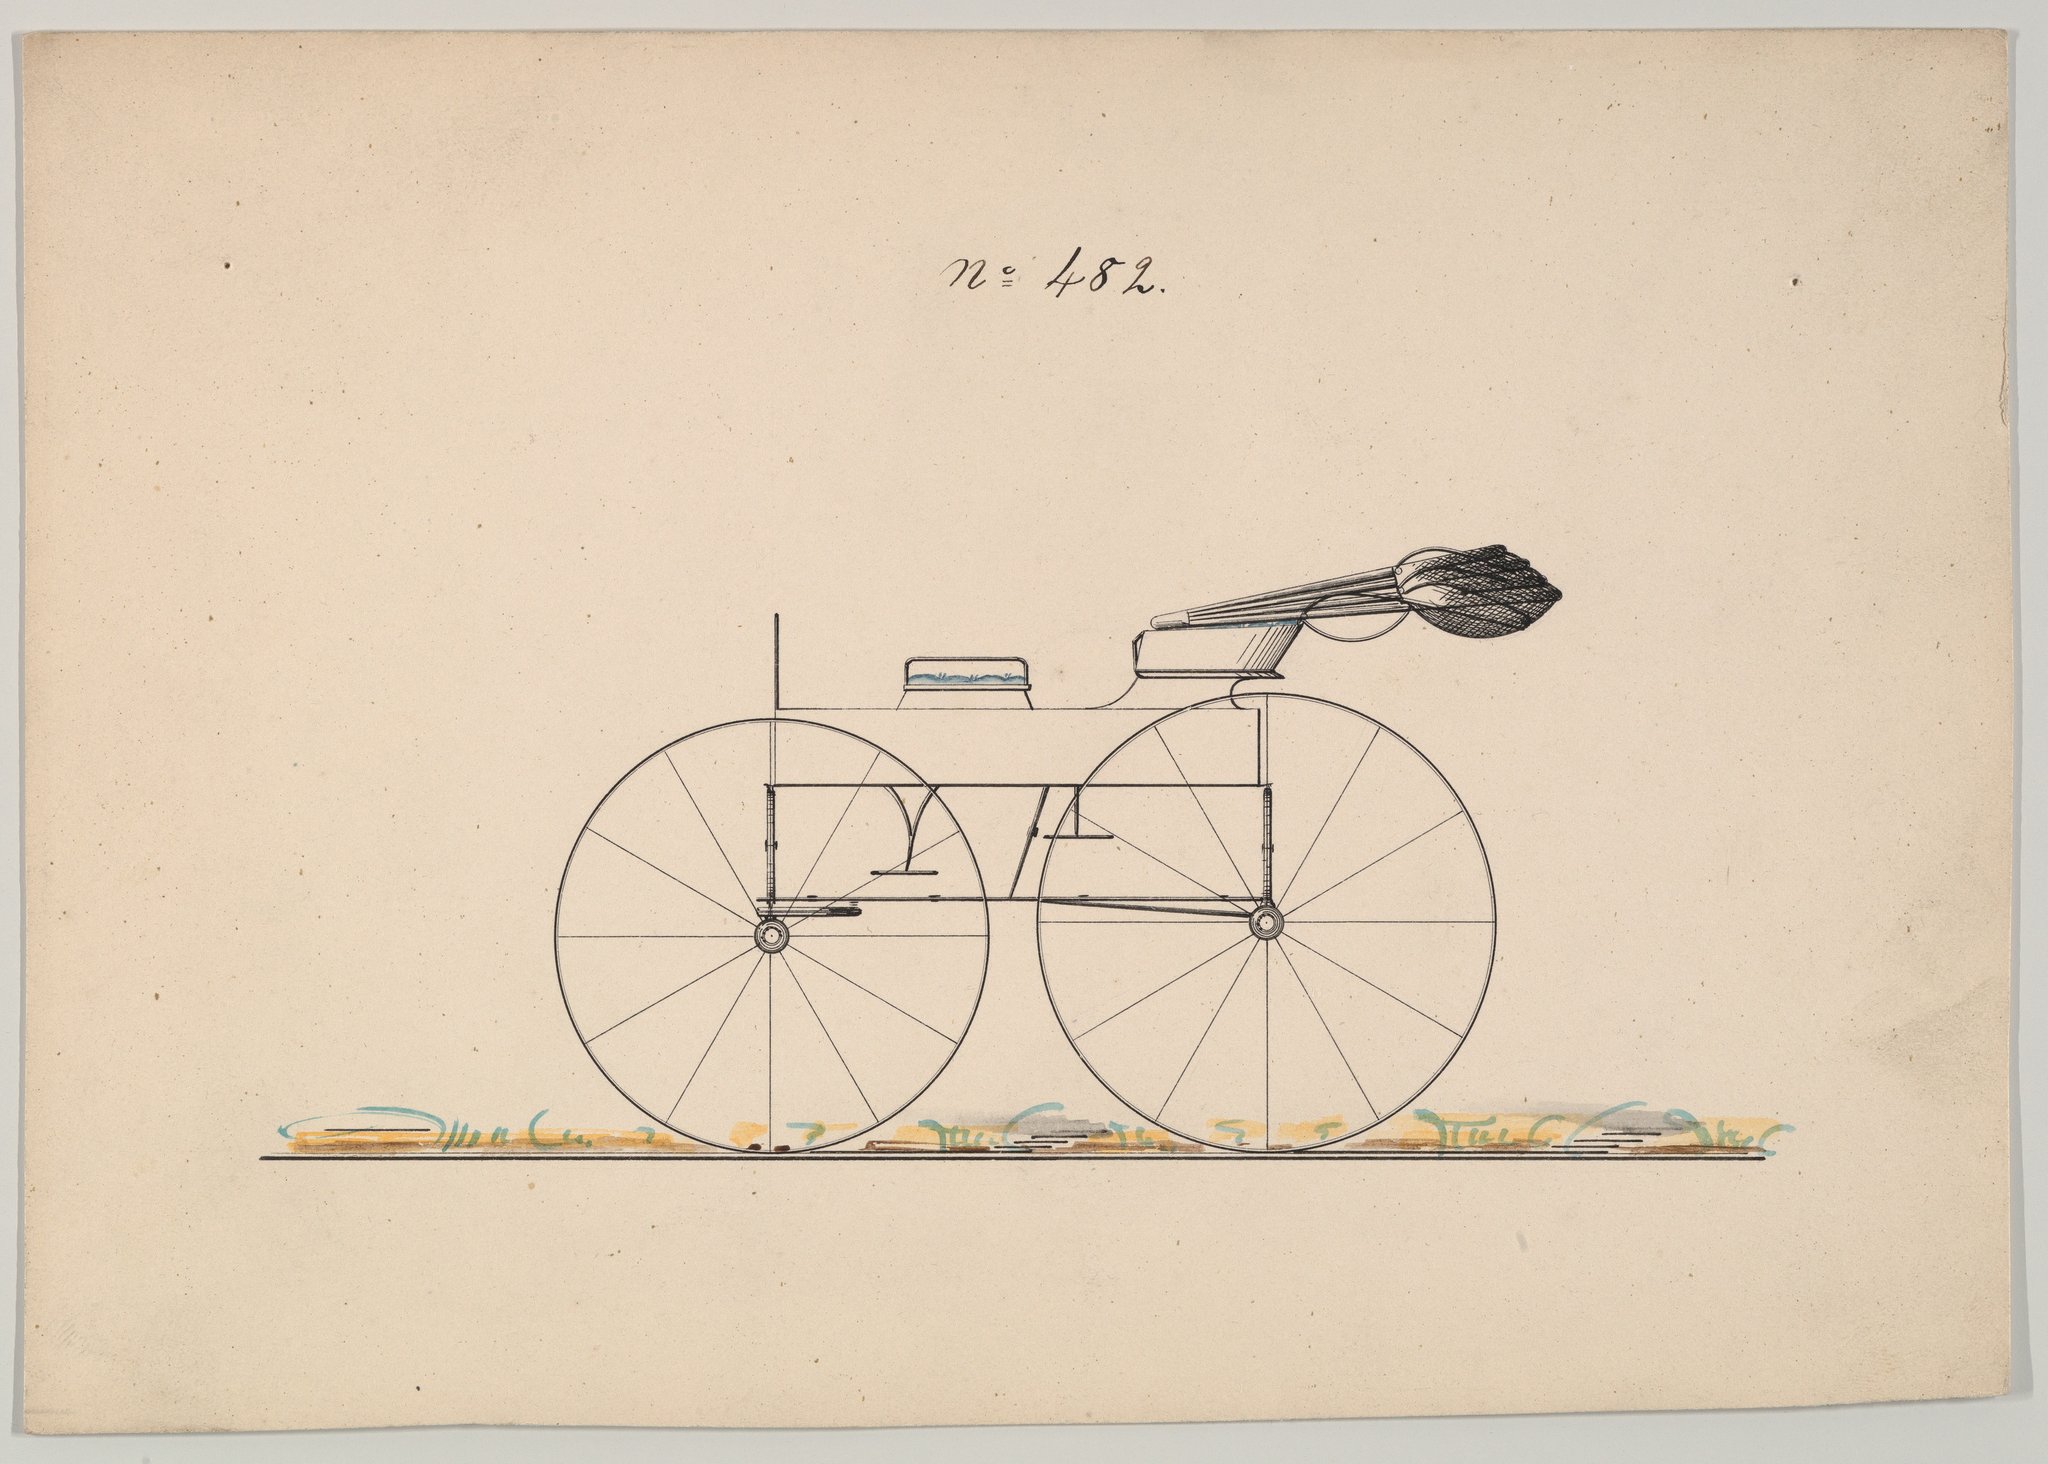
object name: drawing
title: Two Seat Wagon #482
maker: brewster & co.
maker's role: manufacturer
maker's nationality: american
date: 1865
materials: ink, watercolor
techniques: pen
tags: carriages